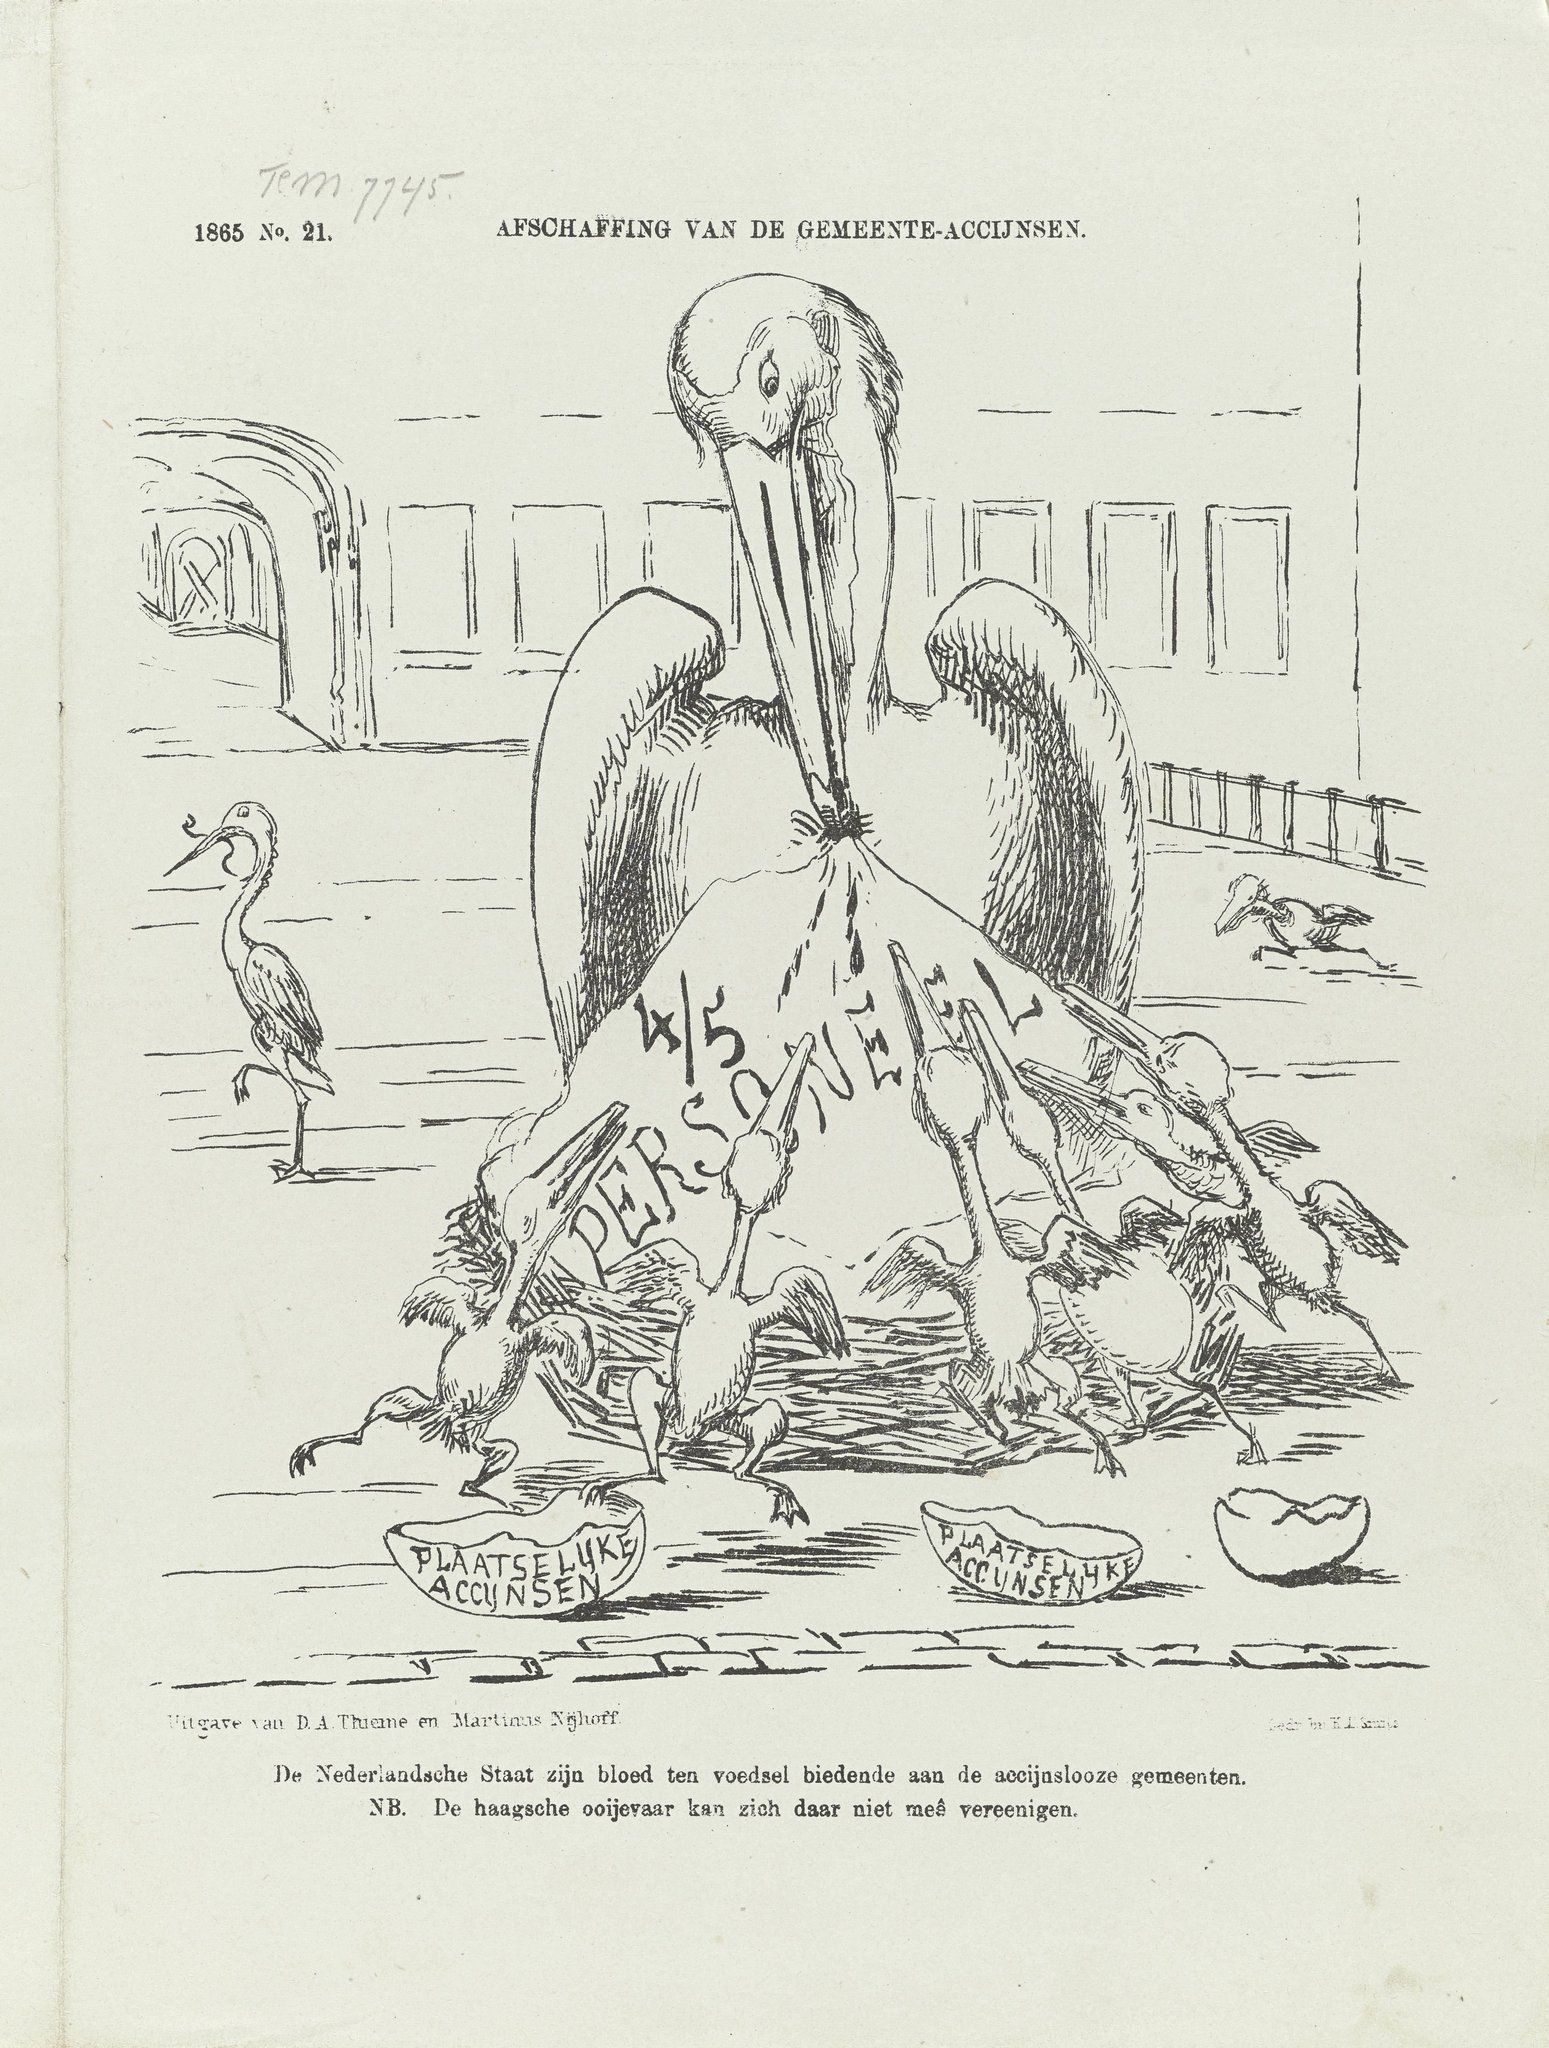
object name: print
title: Afschaffing van de gemeente-accijnsen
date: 1865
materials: paper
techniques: lithograph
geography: the hague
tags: water-birds: pelican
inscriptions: collector's mark: Lugt 2228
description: Spotprent op de afschaffing van de gemeenteaccijnsen, waarbij 4/5 van de rijksbelasting op het personeel aan de gemeente werd afgestaan. Een pelikaan (de Nederlandse staat) voedt haar kinderen. Plaat verschenen bij het weekblad De Nederlandsche Spectator, nr. 21, 27 mei 1865.